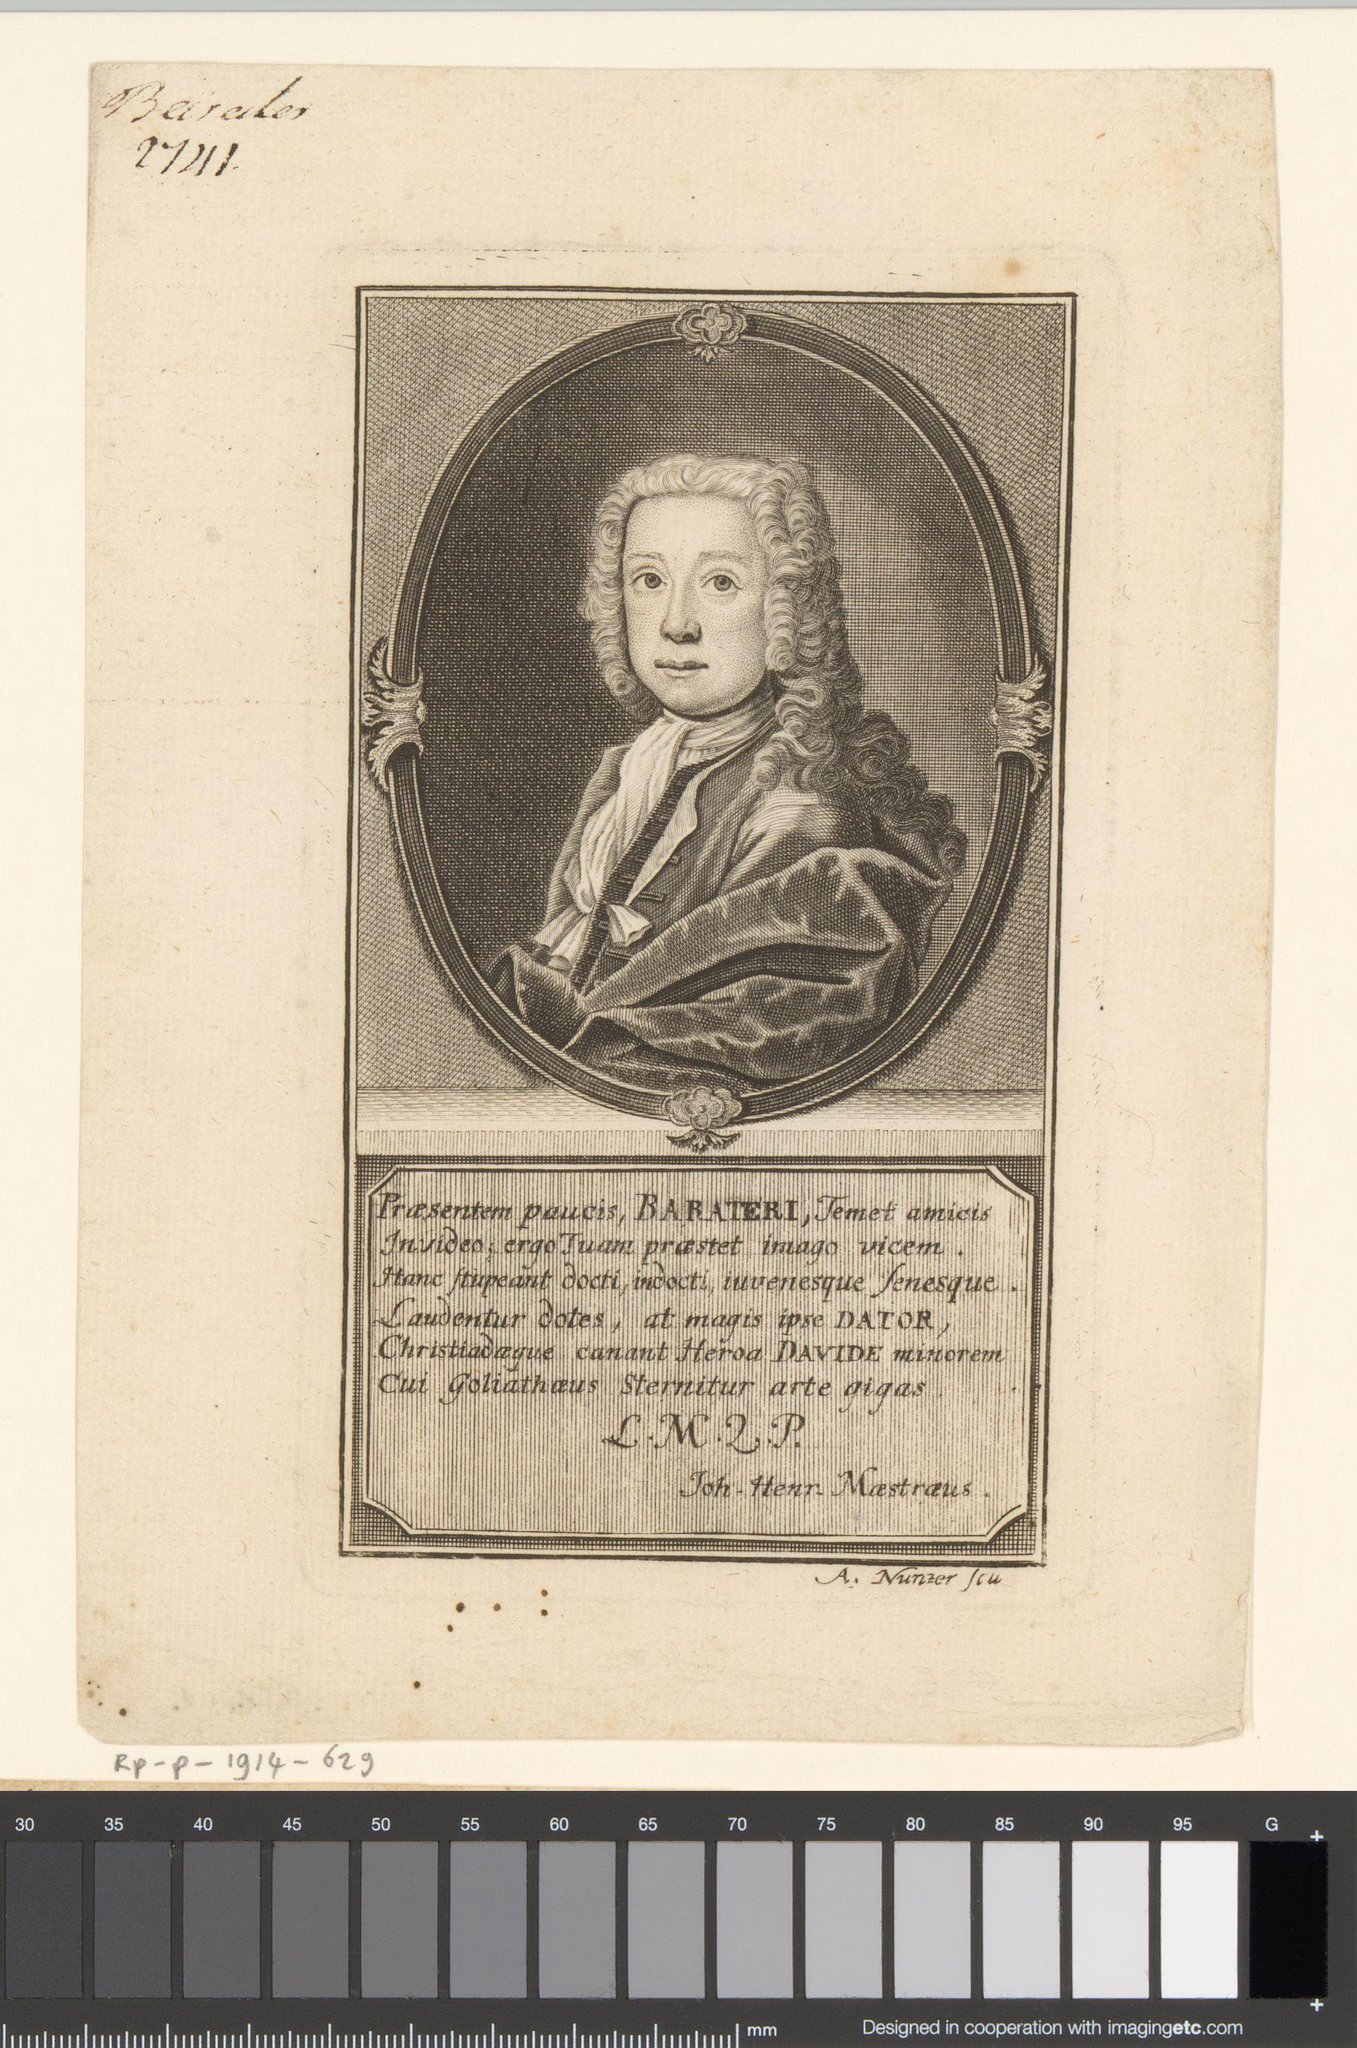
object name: print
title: Portret van Jean-Philippe Baratier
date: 1700-1749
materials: paper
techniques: engraving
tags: schwabach, historicus, geleerde, oriëntalist, mathematicus, jean-philippe baratier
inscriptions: collector's mark: Lugt 2228